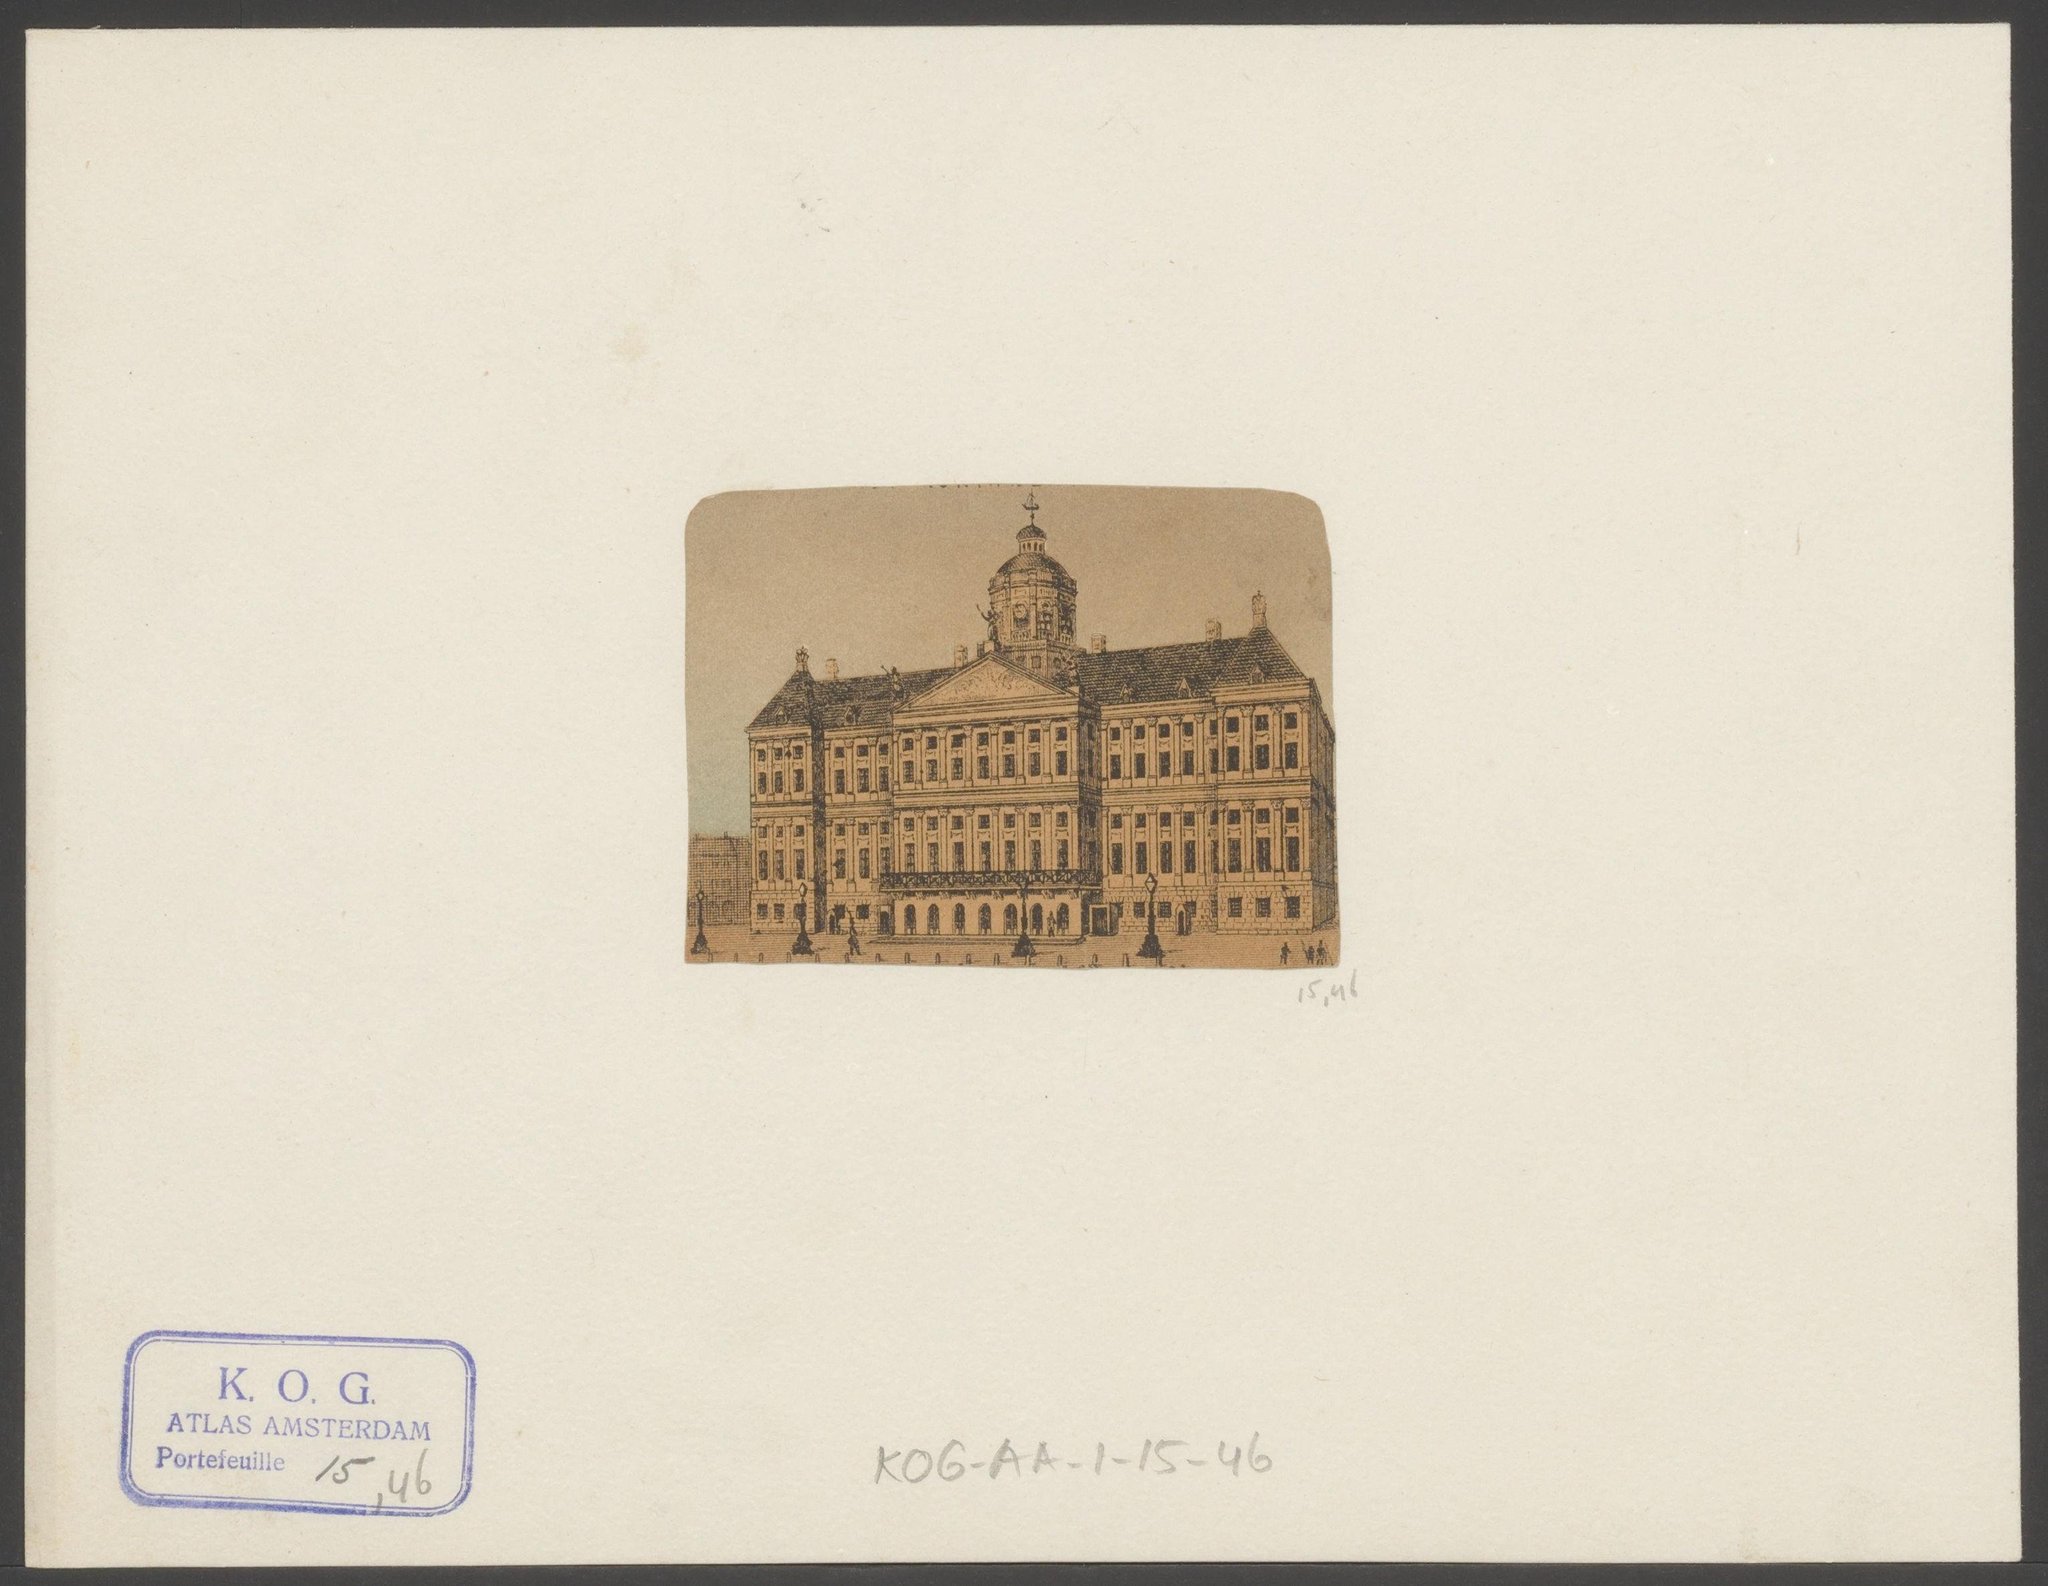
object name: print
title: Gezicht op het Paleis op de Dam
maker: Anonymous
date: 1800-1899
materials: paper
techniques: etching, iris print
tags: square, place, circus, etc., city-view in general; 'veduta', townhall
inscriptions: collector's mark: ‘15,46’ Lugt 1641b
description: Onderwerpsrubriek binnen de Atlas Amsterdam: Nieuwe Stadhuis, als Paleis, op de Dam, van Buiten.